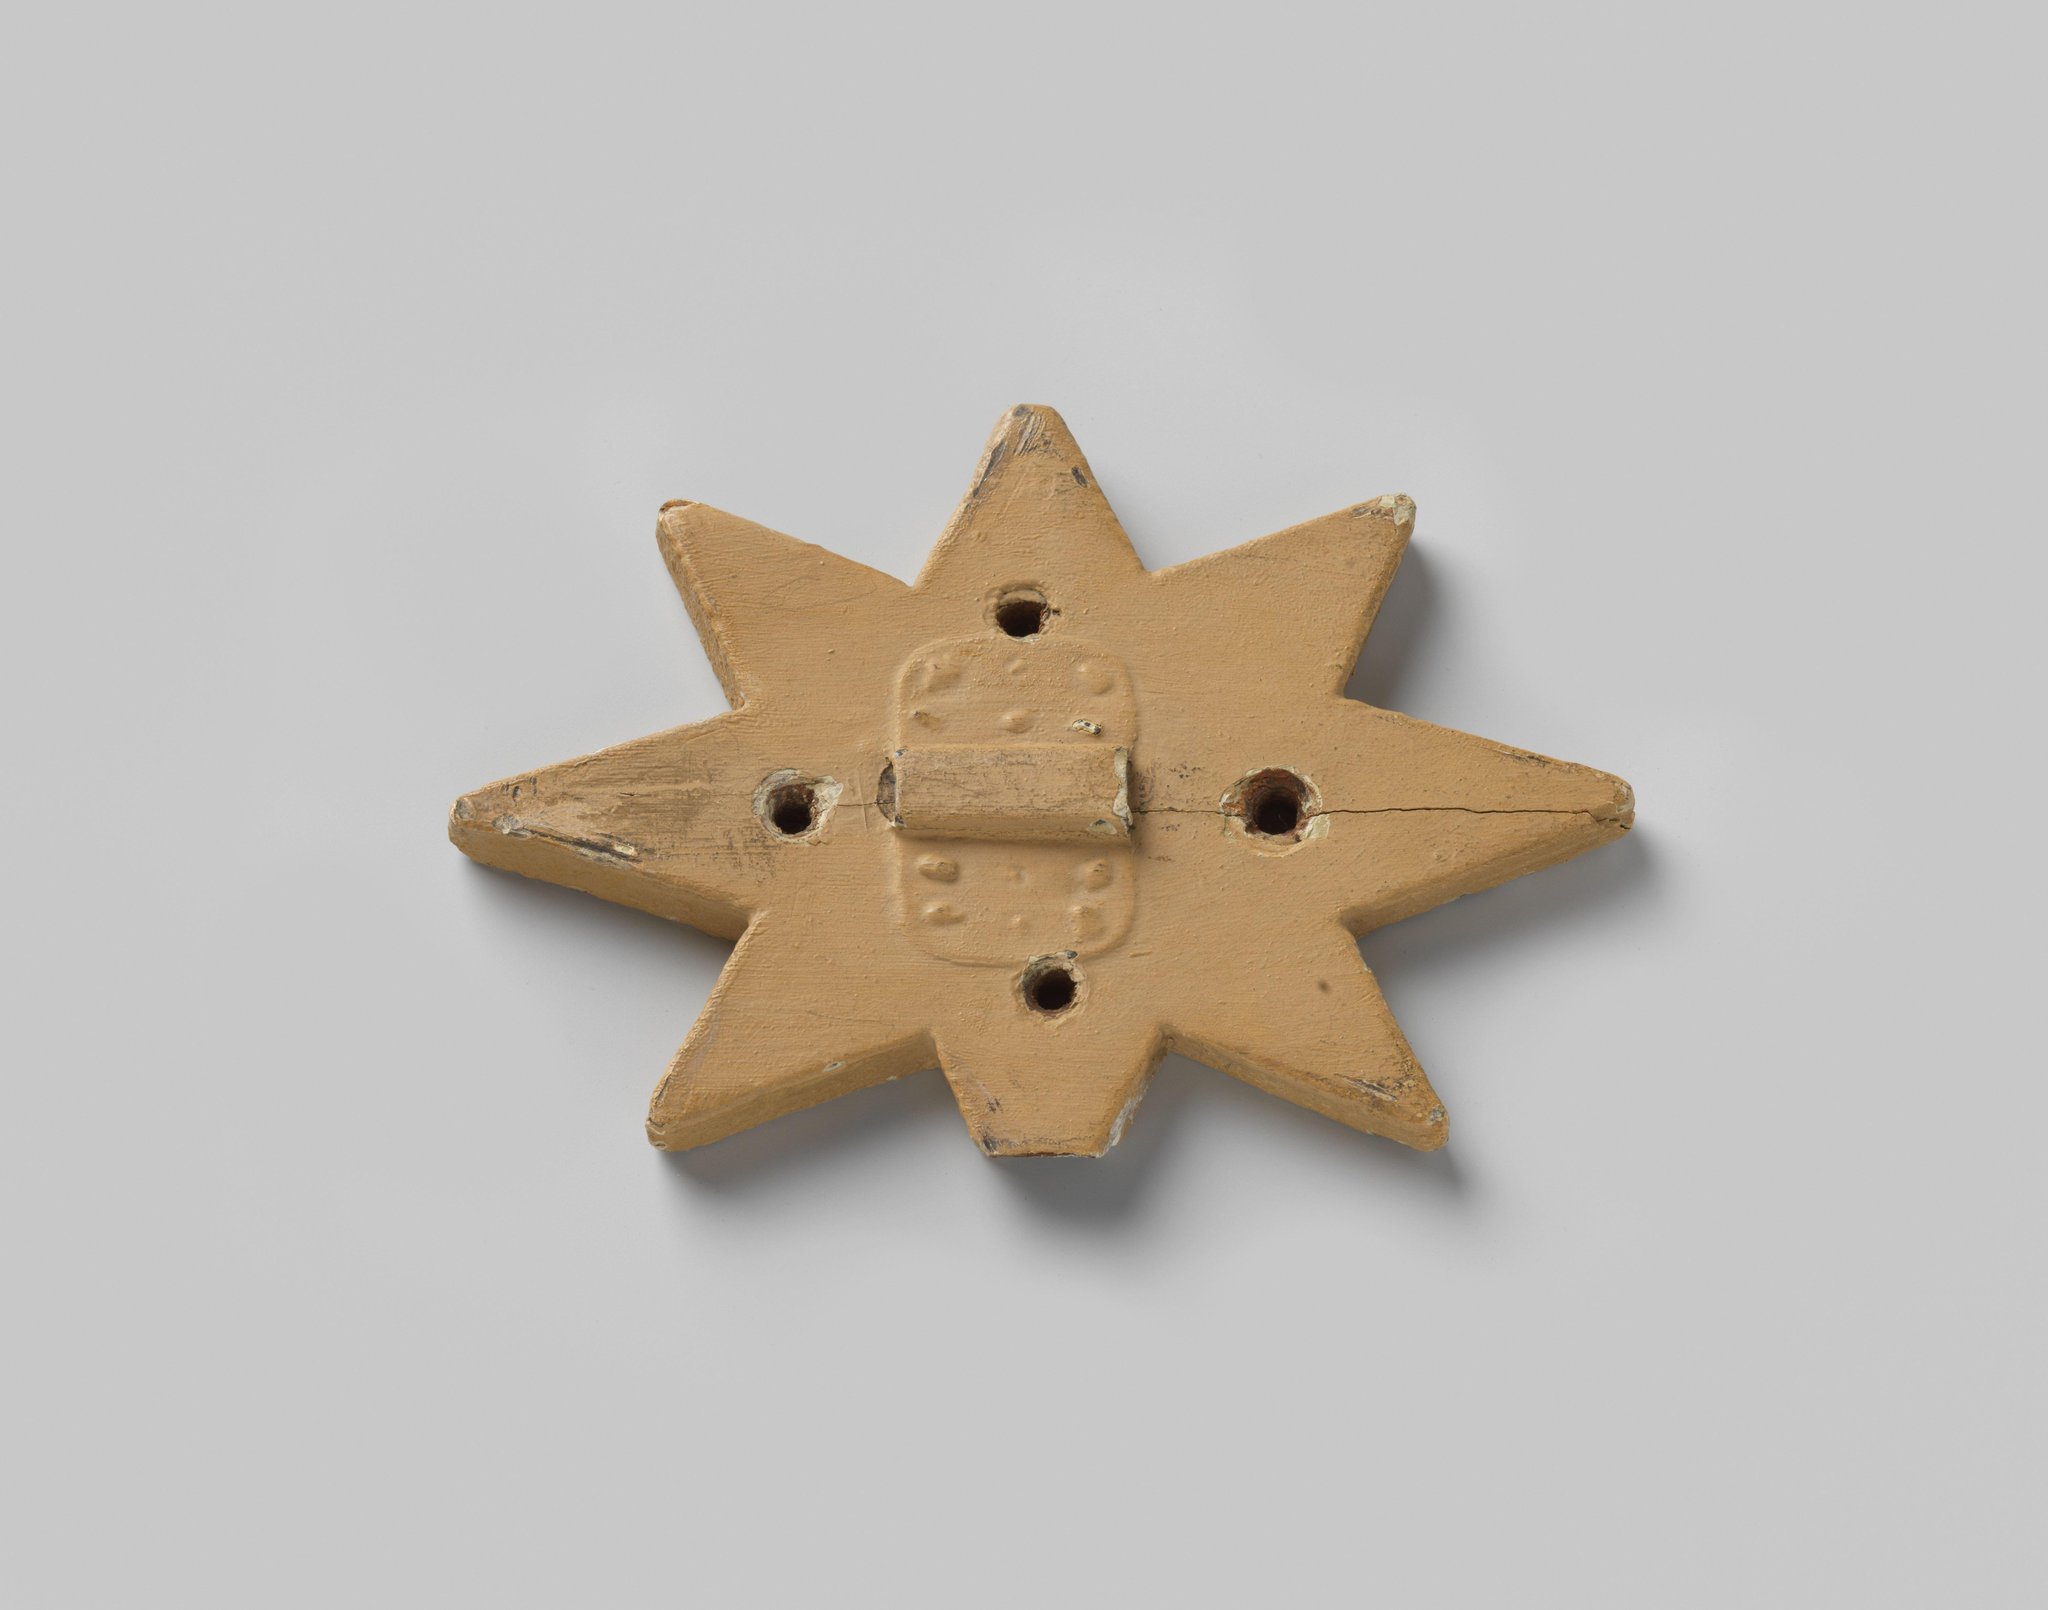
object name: bevestigingsmiddel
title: Bevestigingsplaat van hout van een zilveren wandarm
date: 1800-1899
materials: metal, wood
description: Stervormige wandplaat van hout van een zilveren wandarm.